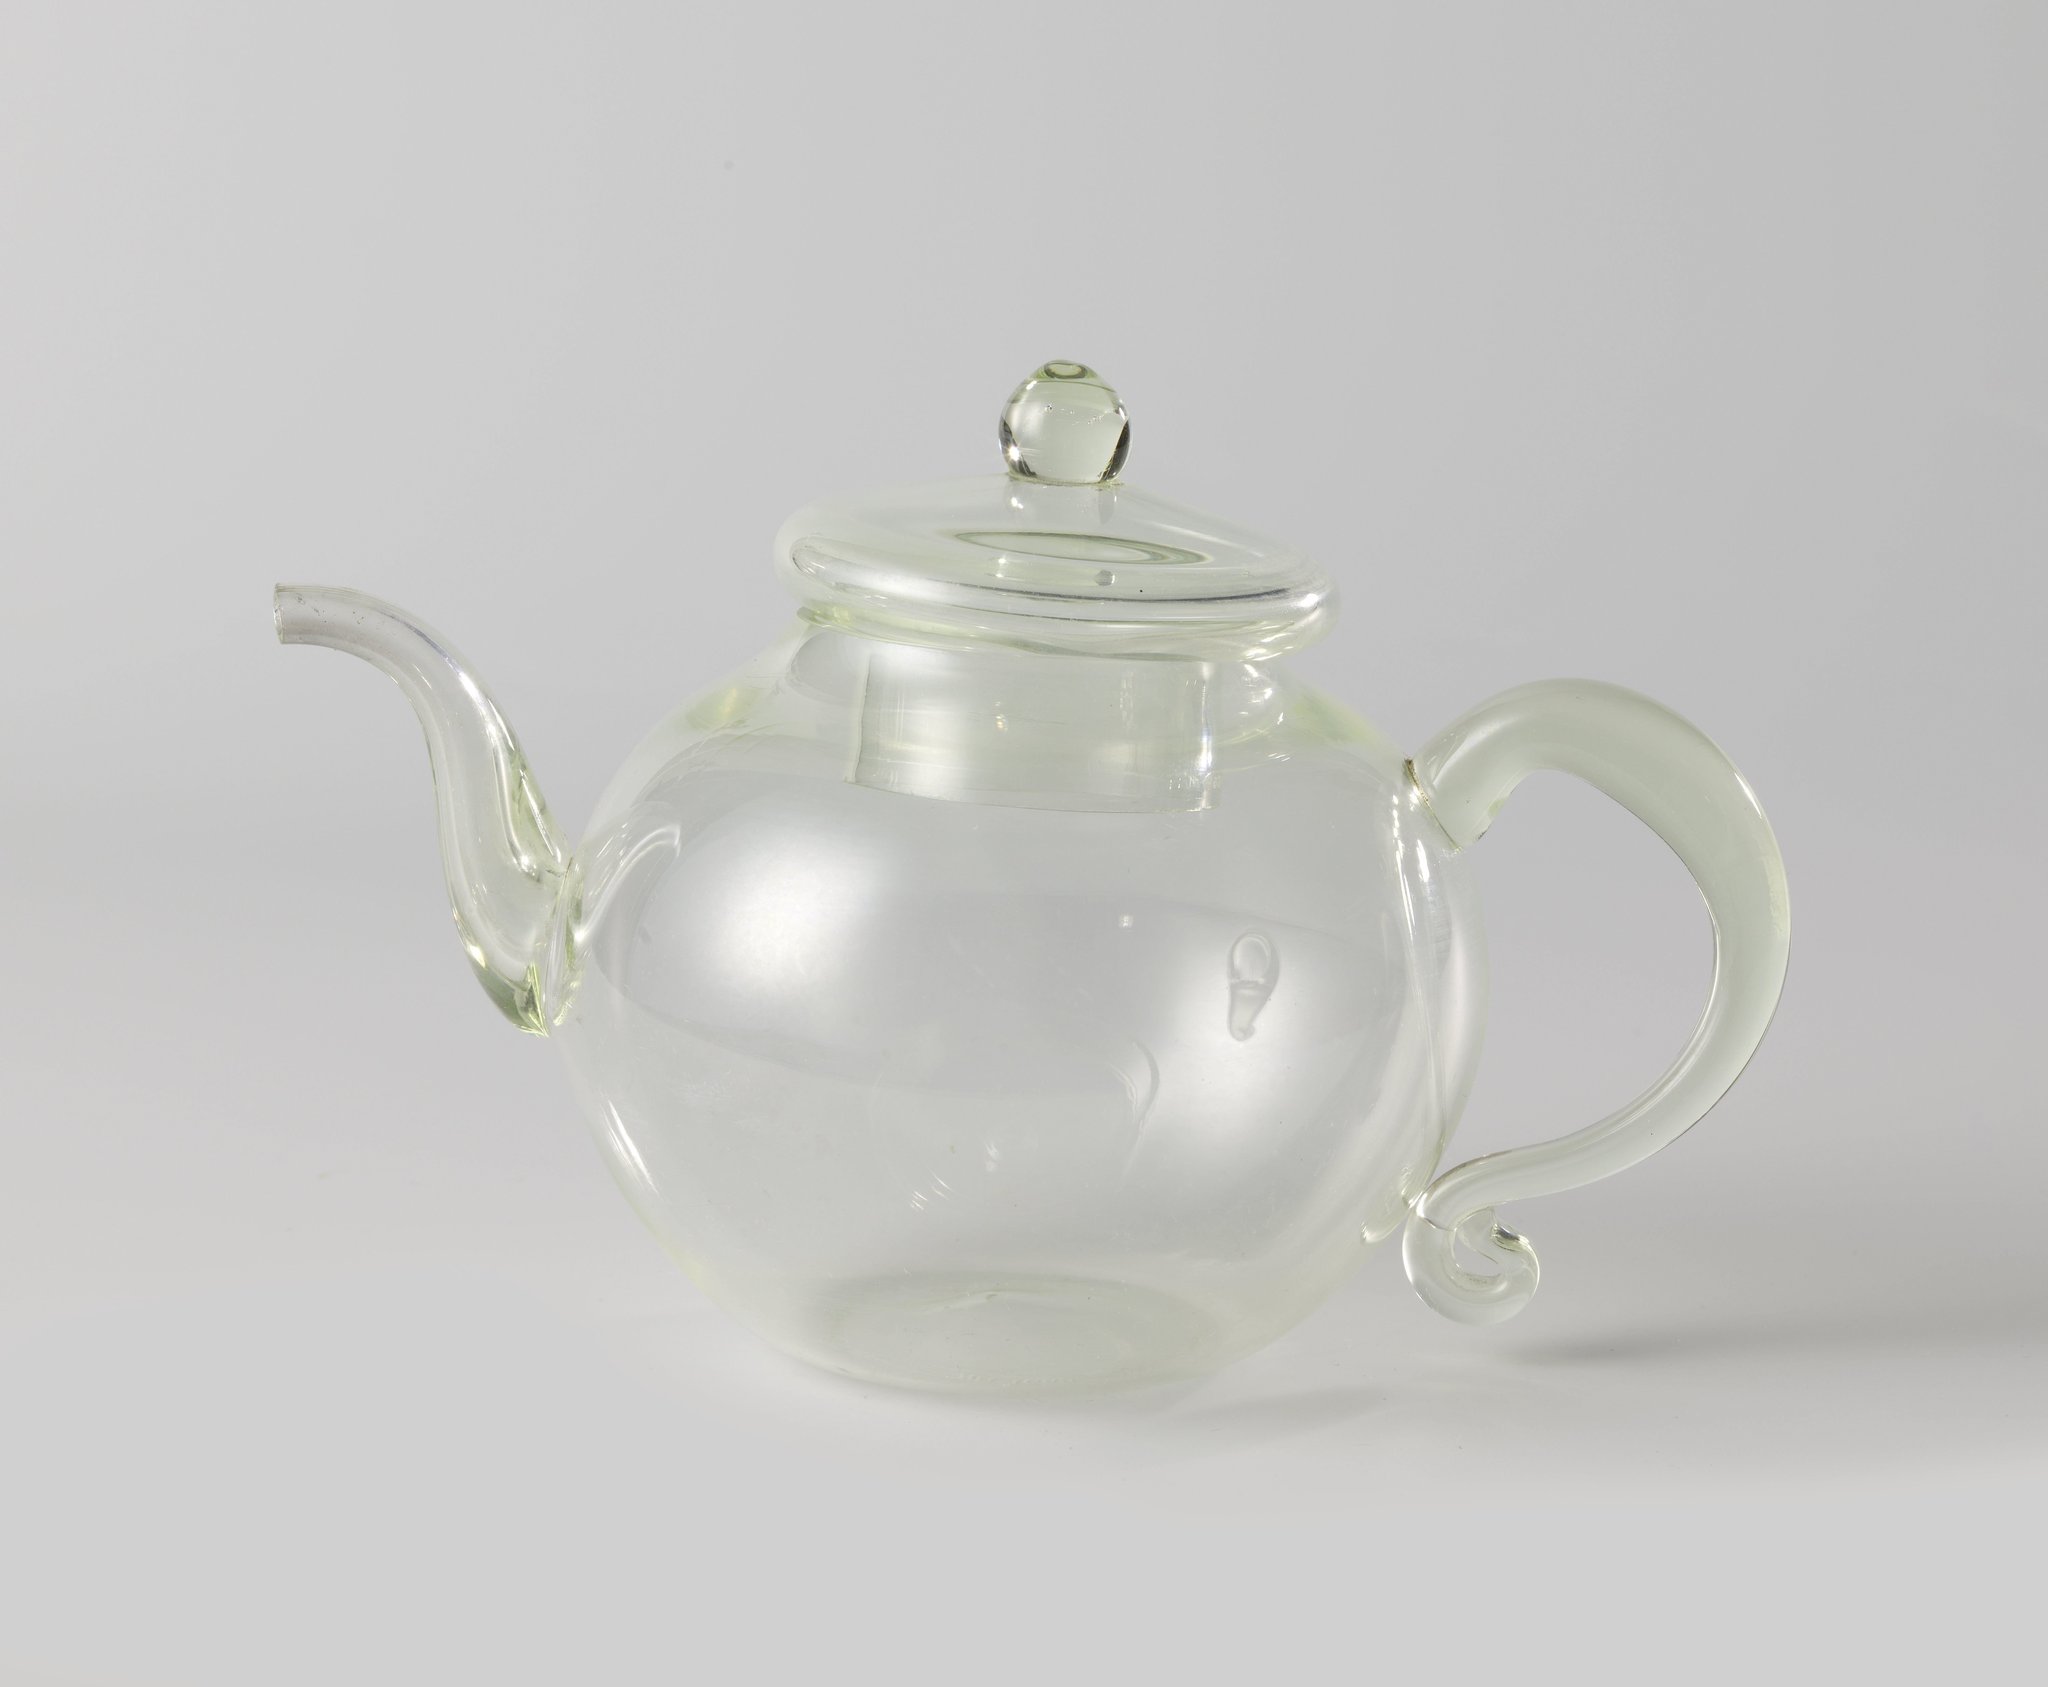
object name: teapot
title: Theepot met deksel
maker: Anonymous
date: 1750-1800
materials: glass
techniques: glassblowing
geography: japan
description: Bolvormig lichaam, gebogen tuit en c-vormig handvat. Overkragend deksel met ronde knop.